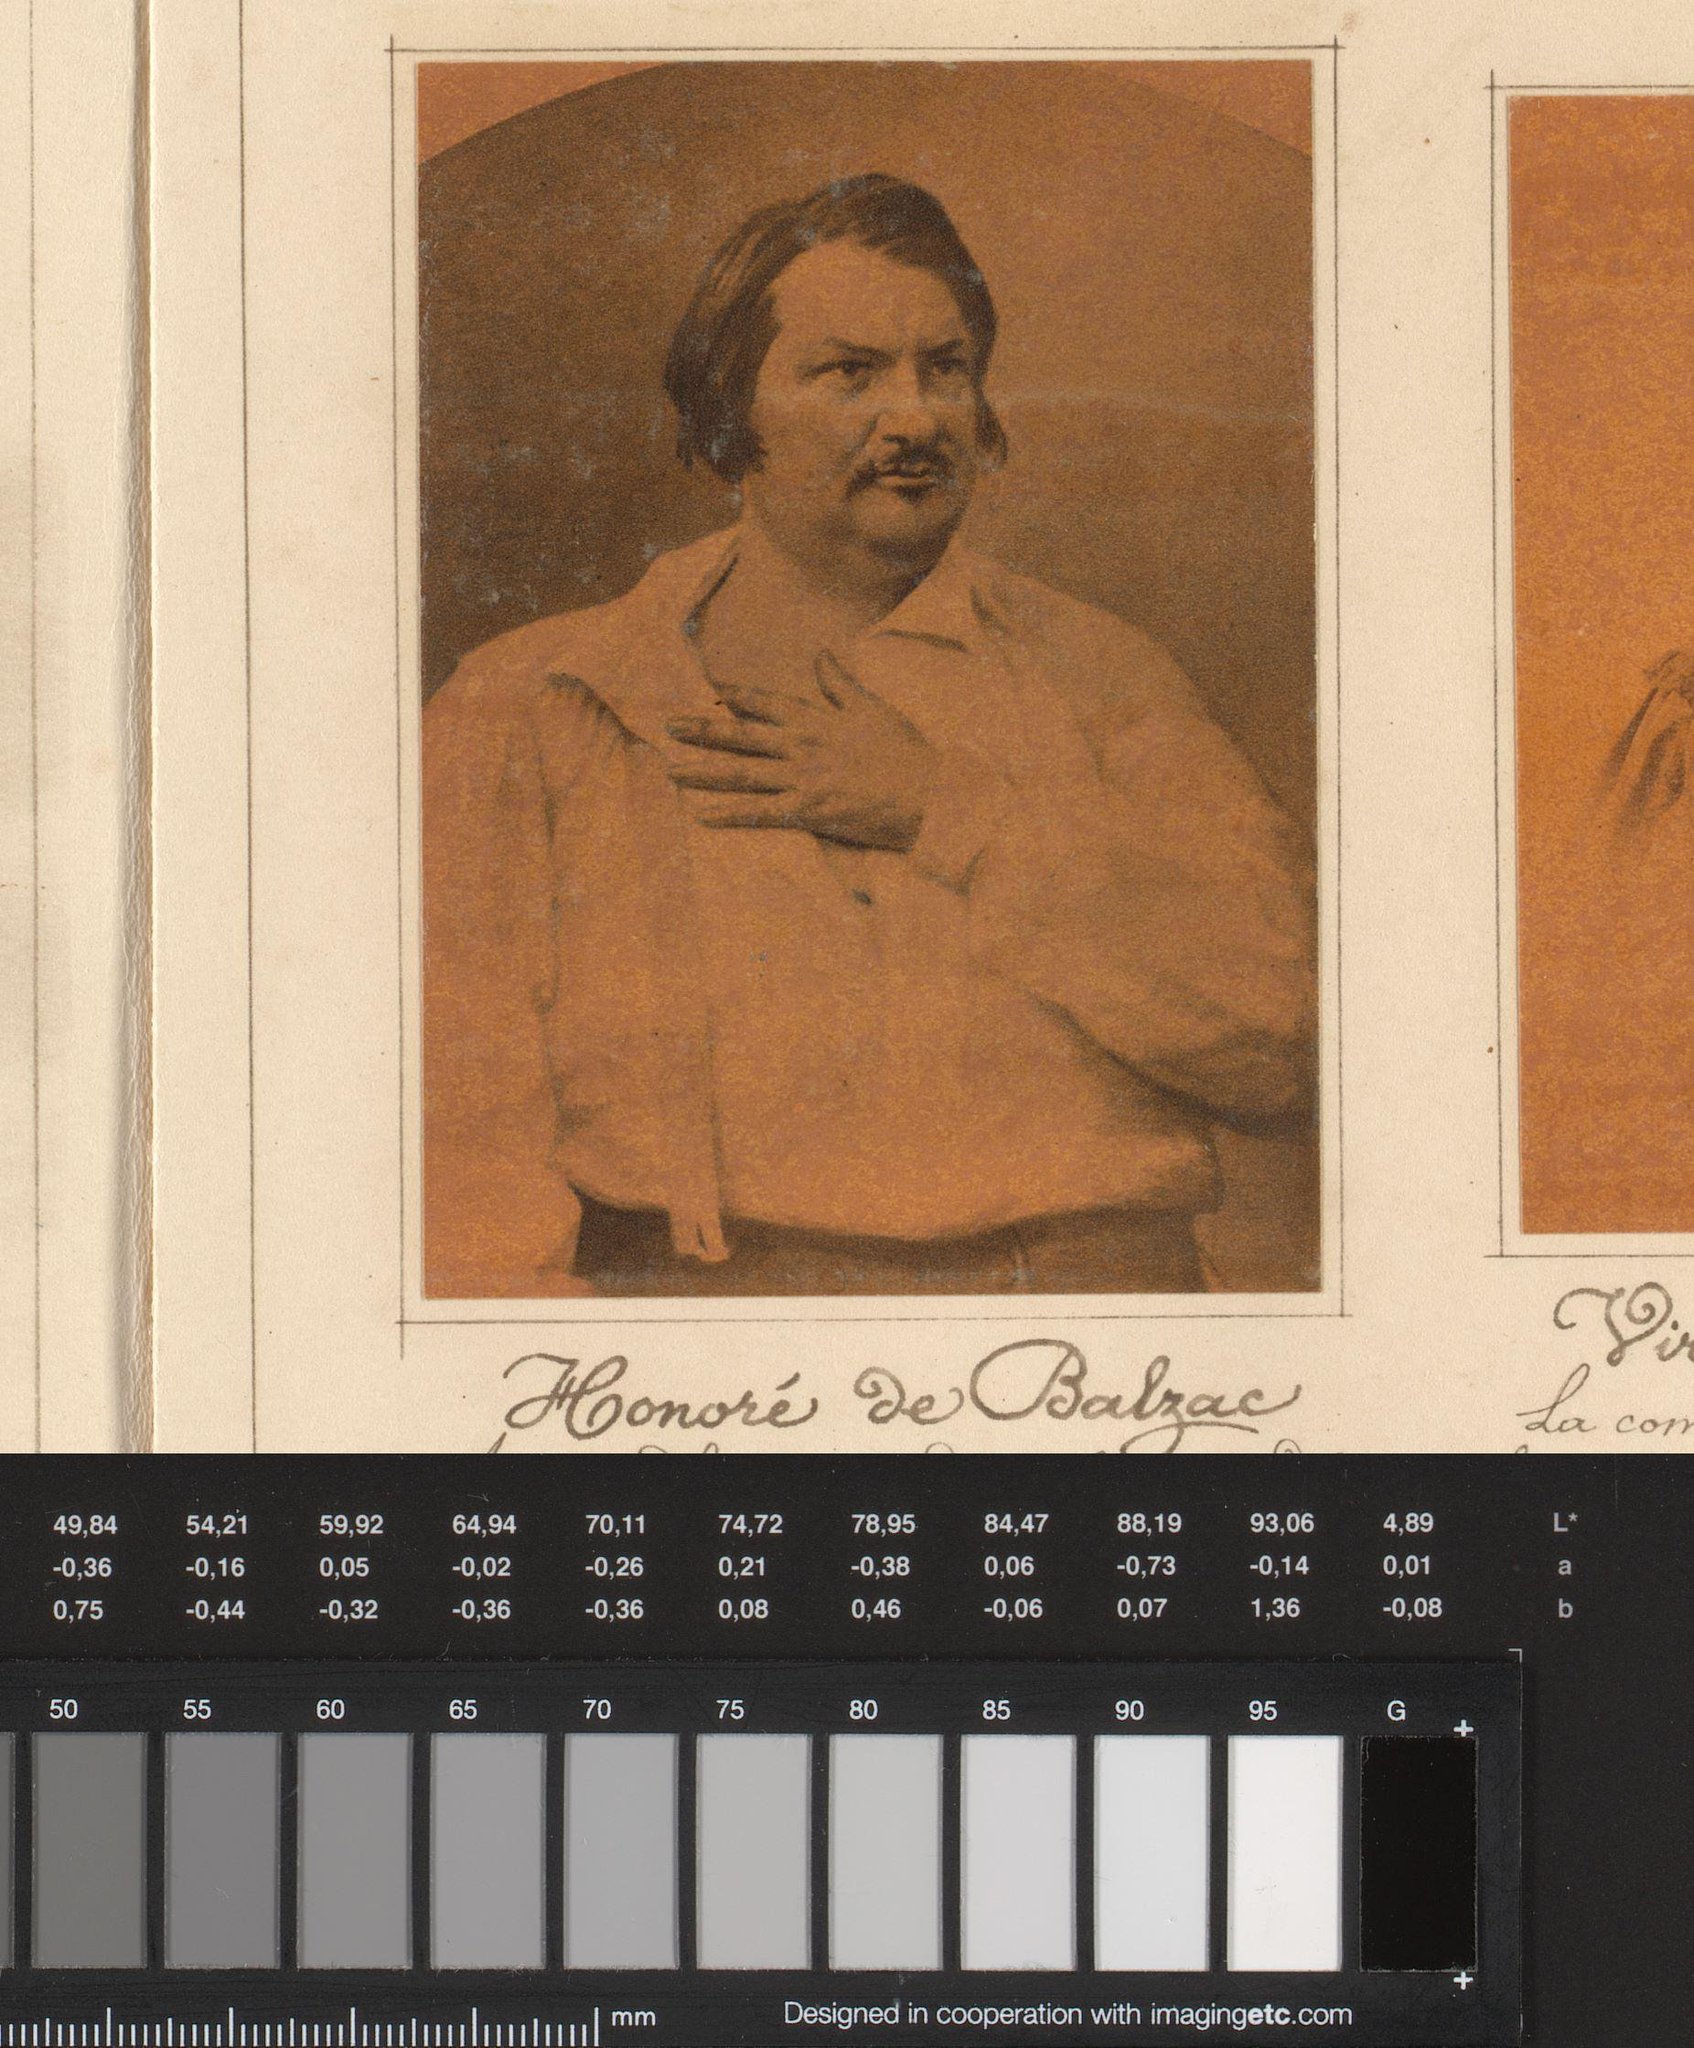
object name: photomechanical print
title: Honoré de Balzac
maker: Anonymous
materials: paper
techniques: rotogravure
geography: france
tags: honoré de balzac, portrait of a writer, france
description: Deze prent maakt deel uit van een album.